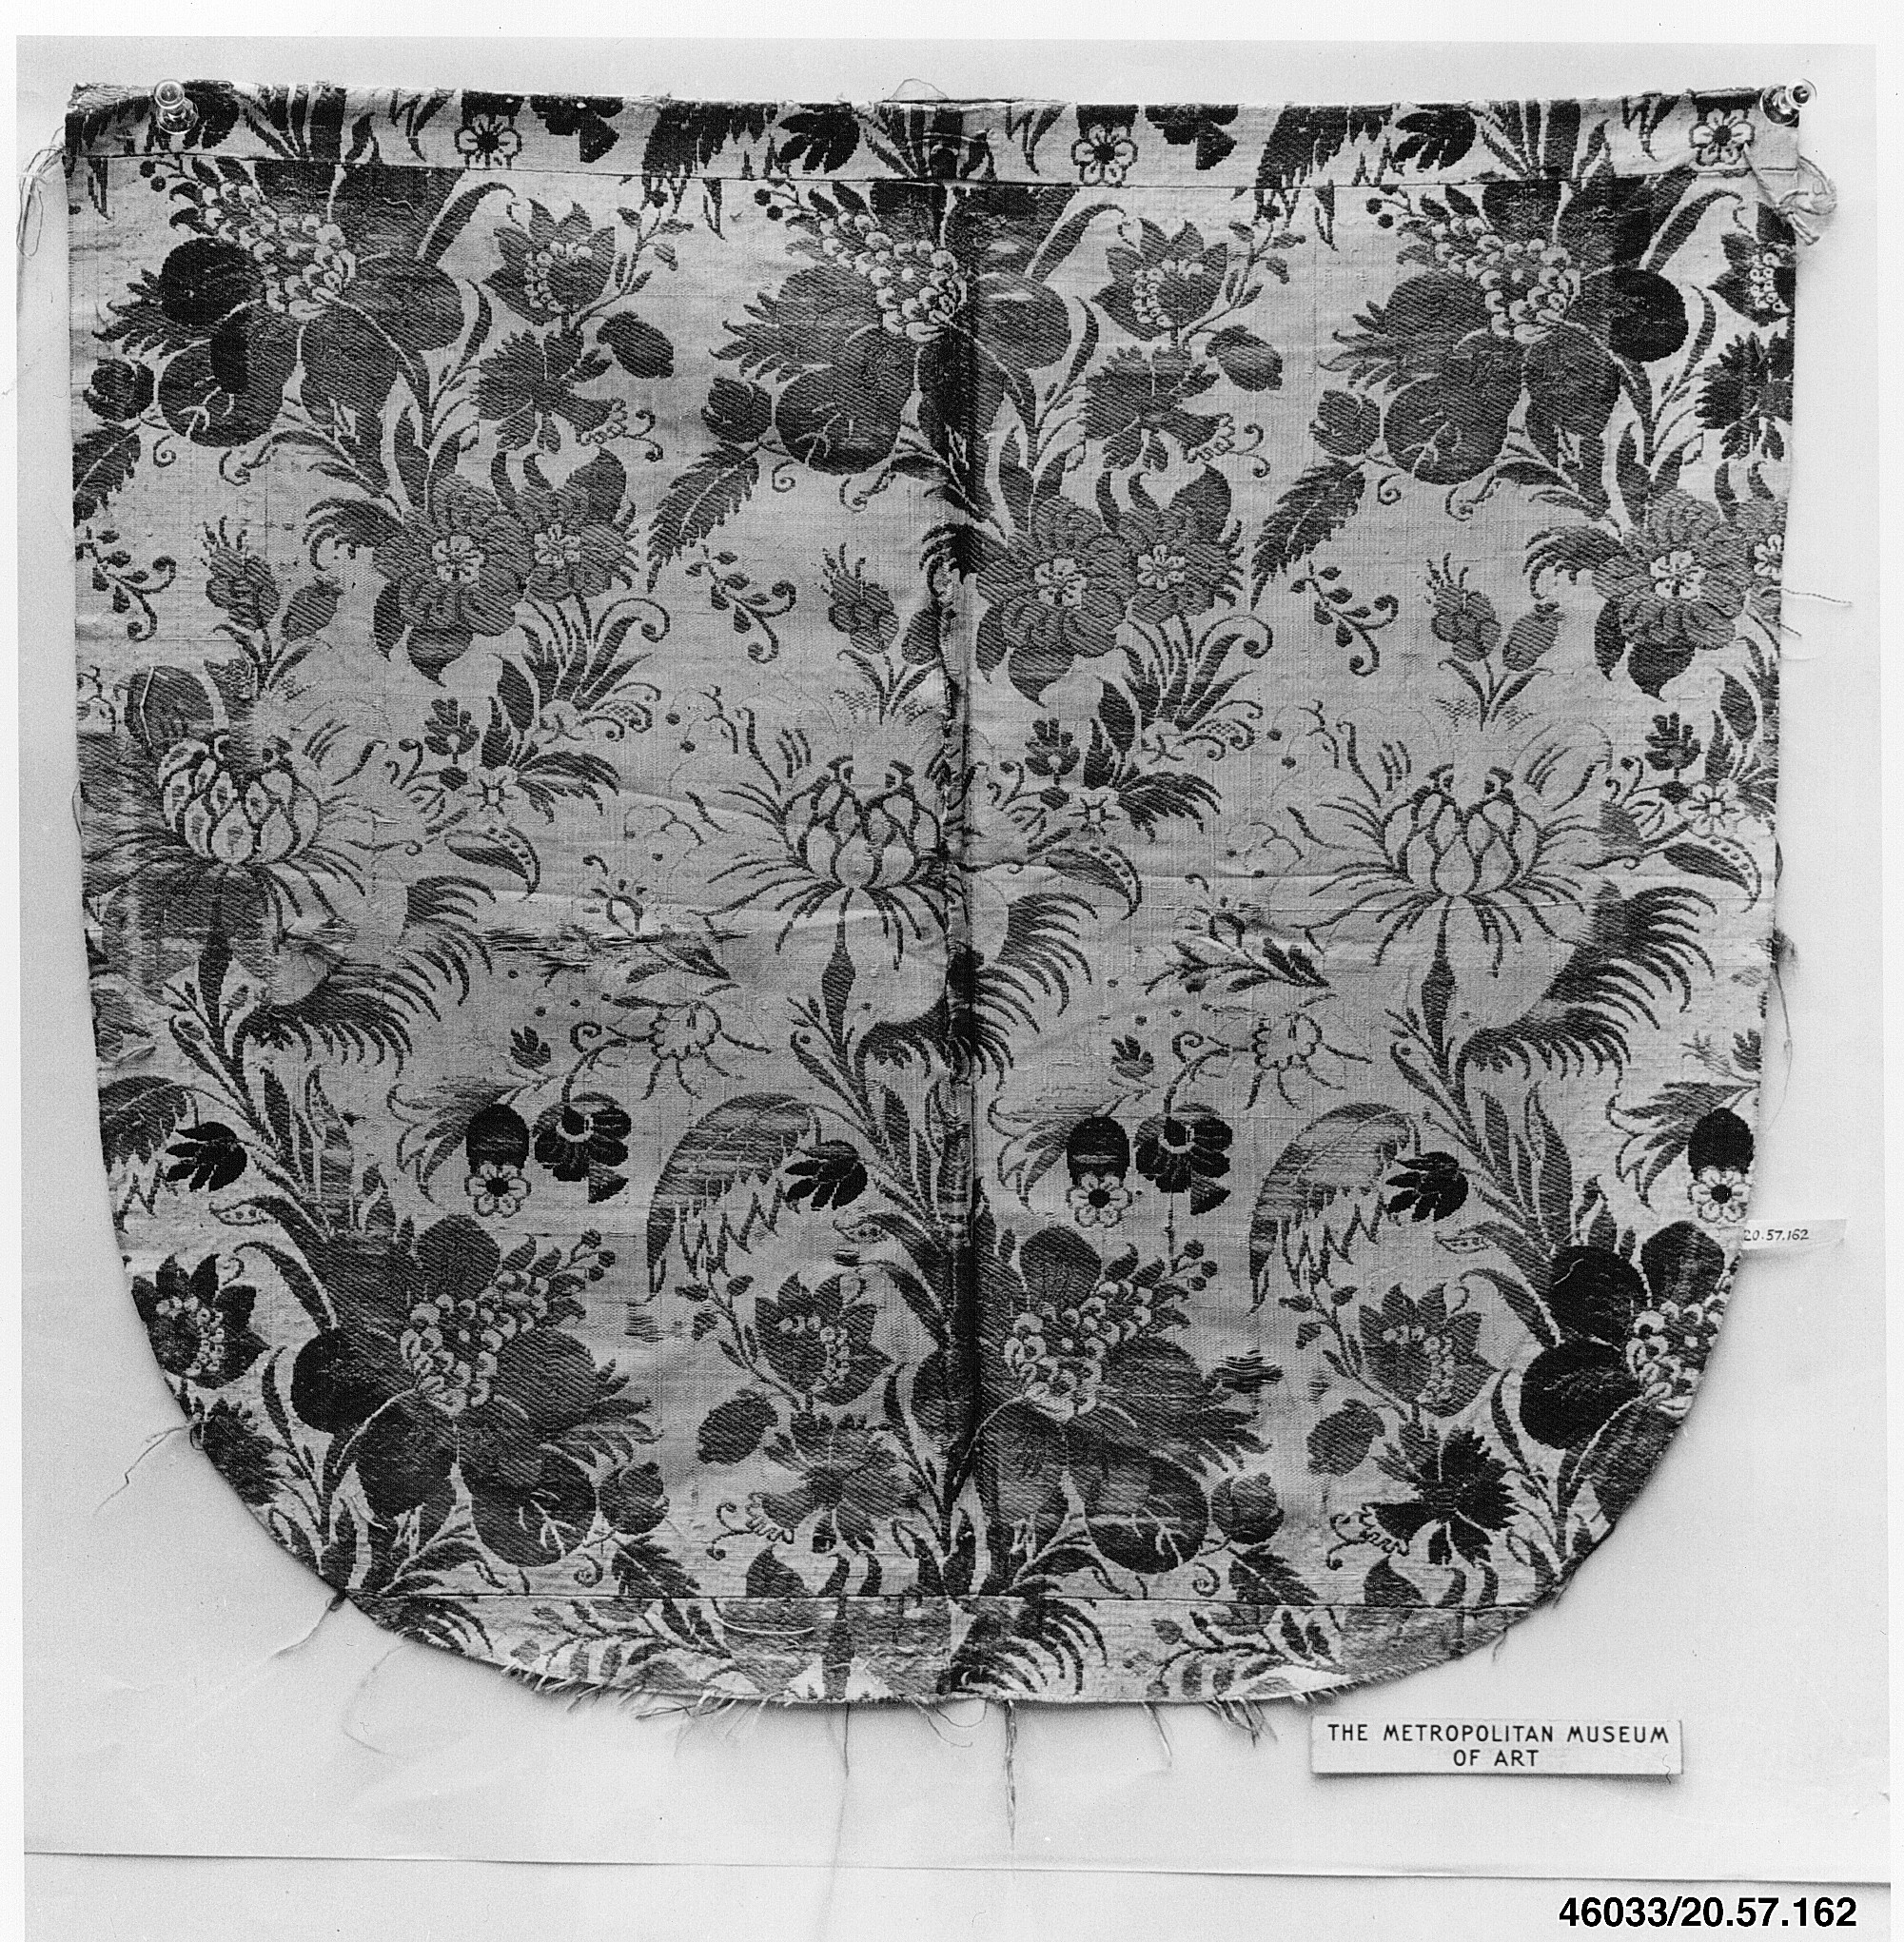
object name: piece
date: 1750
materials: silk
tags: flowers,leaves